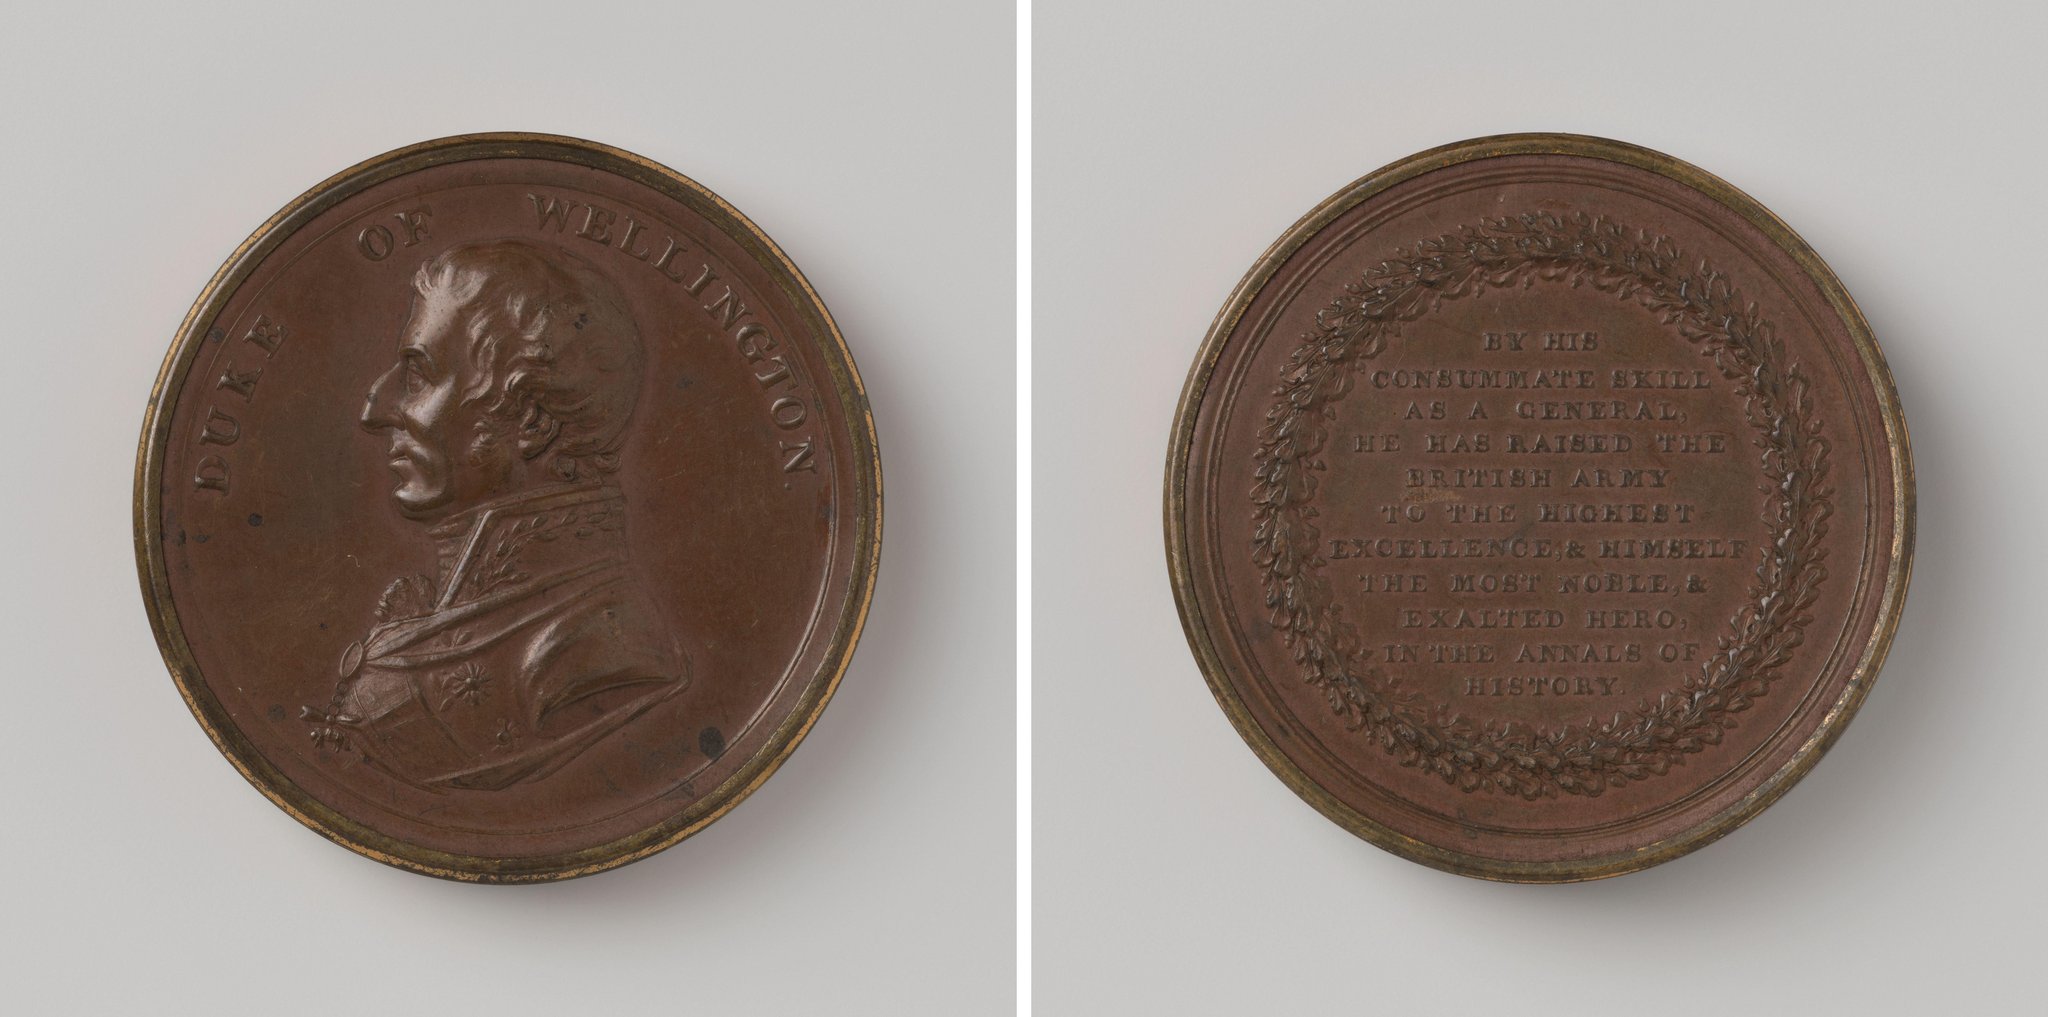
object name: history medal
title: Arthur Wellesley, hertog van Wellington, ter ere van zijn overwinningen in Portugal, Spanje, Frankrijk en België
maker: Anonymous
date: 1815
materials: bronze, paper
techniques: striking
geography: england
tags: walmer castle, arthur wellesley of wellington, france, spain, belgium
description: Bronzen penning. Voorzijde: borststuk man binnen omschrift. Keerzijde: opschrift binnen eikekrans; inhoud: elf ronde plaatjes met opschrift op voorzijde en keerzijde twee ronde plaatjes met opschrift alleen op de voorzijde.